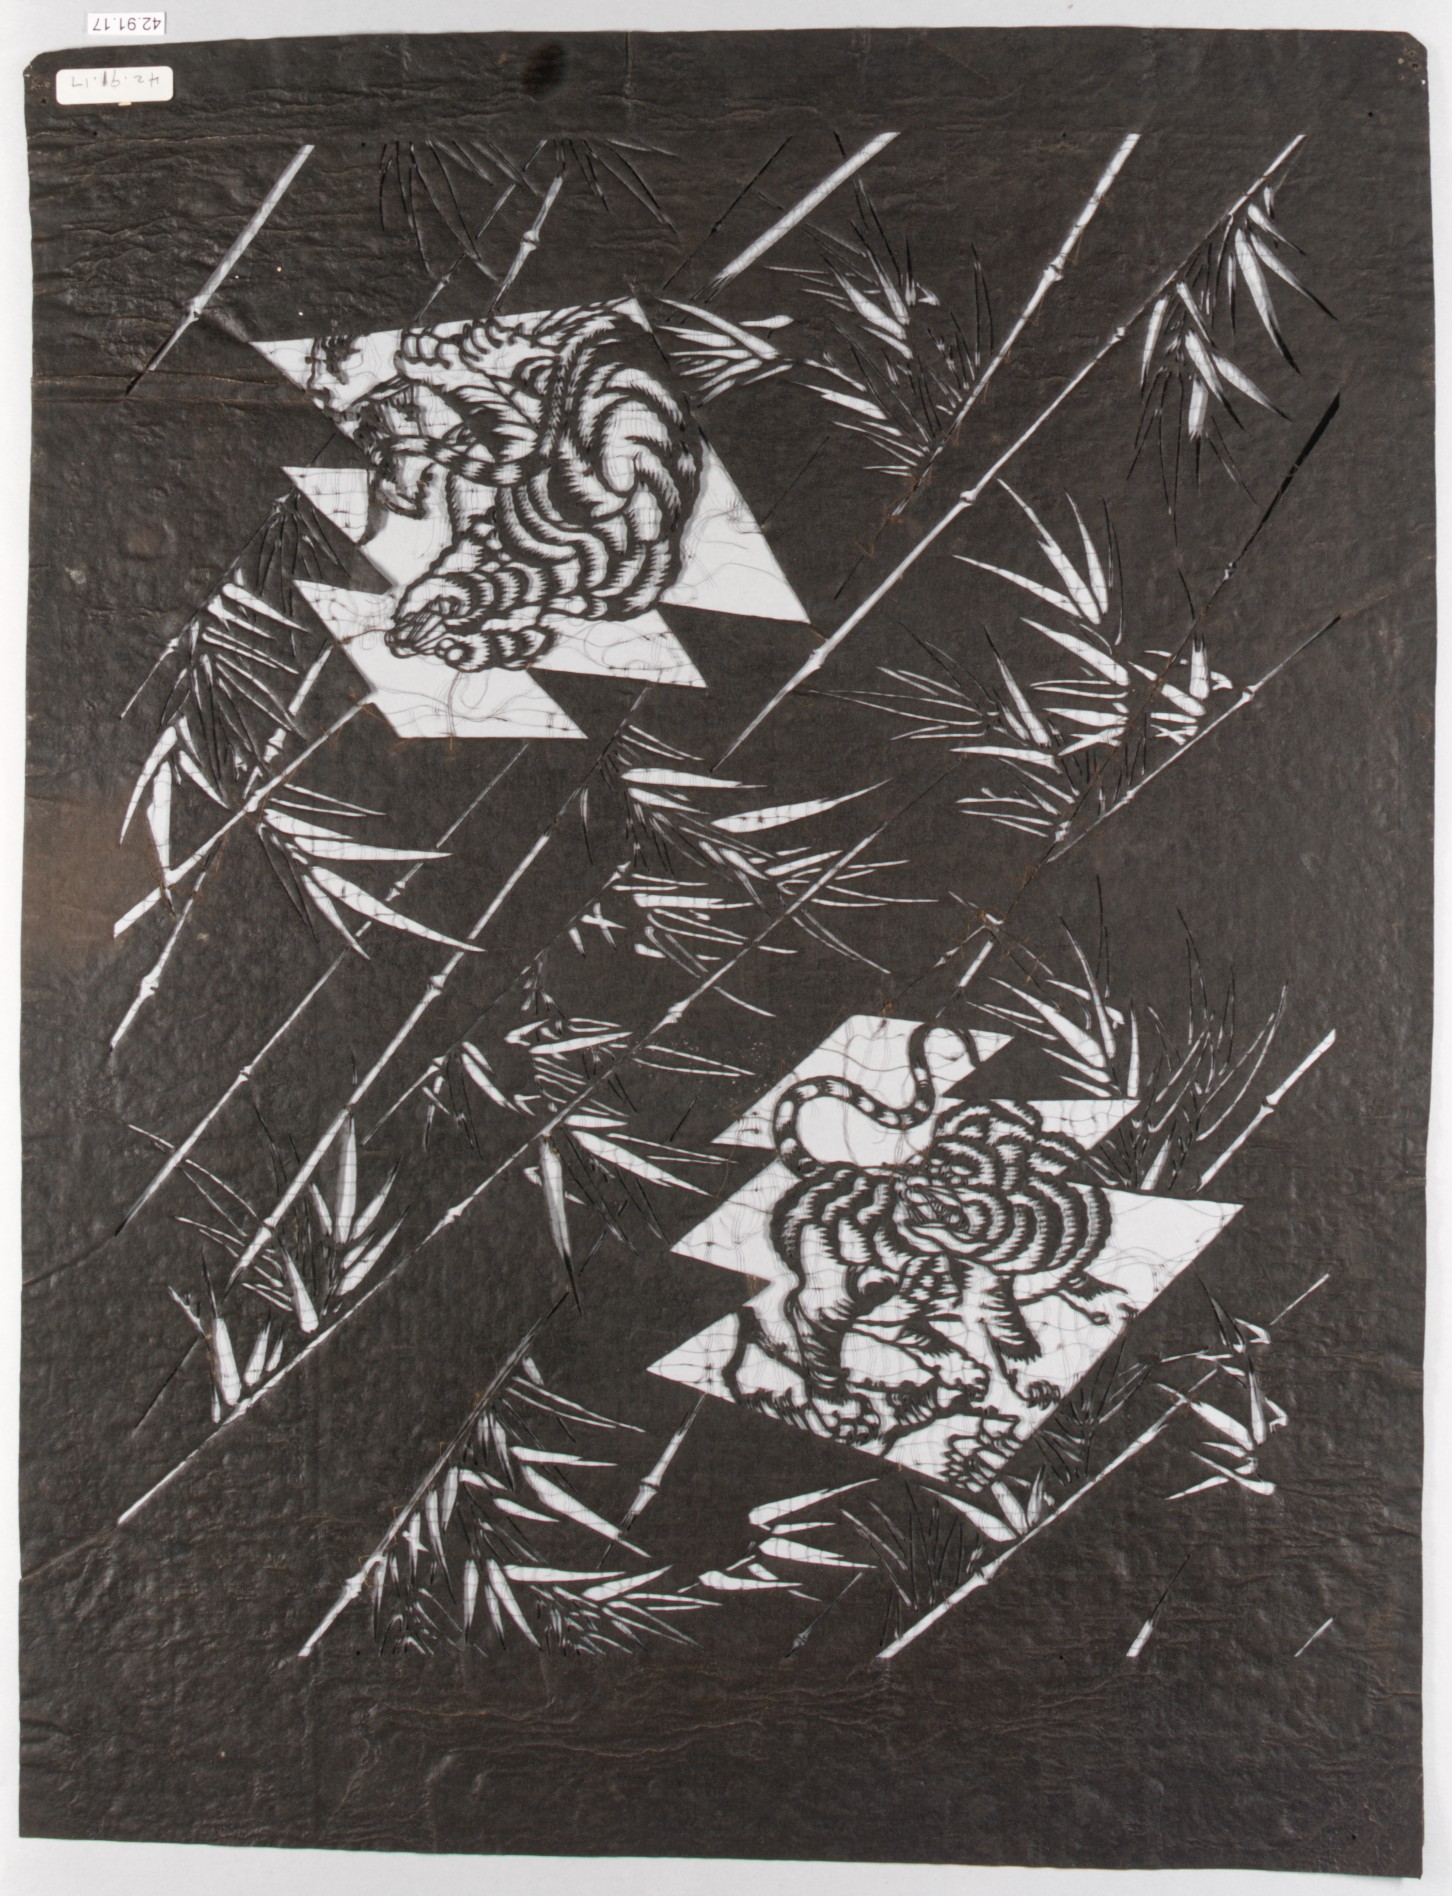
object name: stencil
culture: japanese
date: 1801-1900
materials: paper, silk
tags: tigers,bamboo